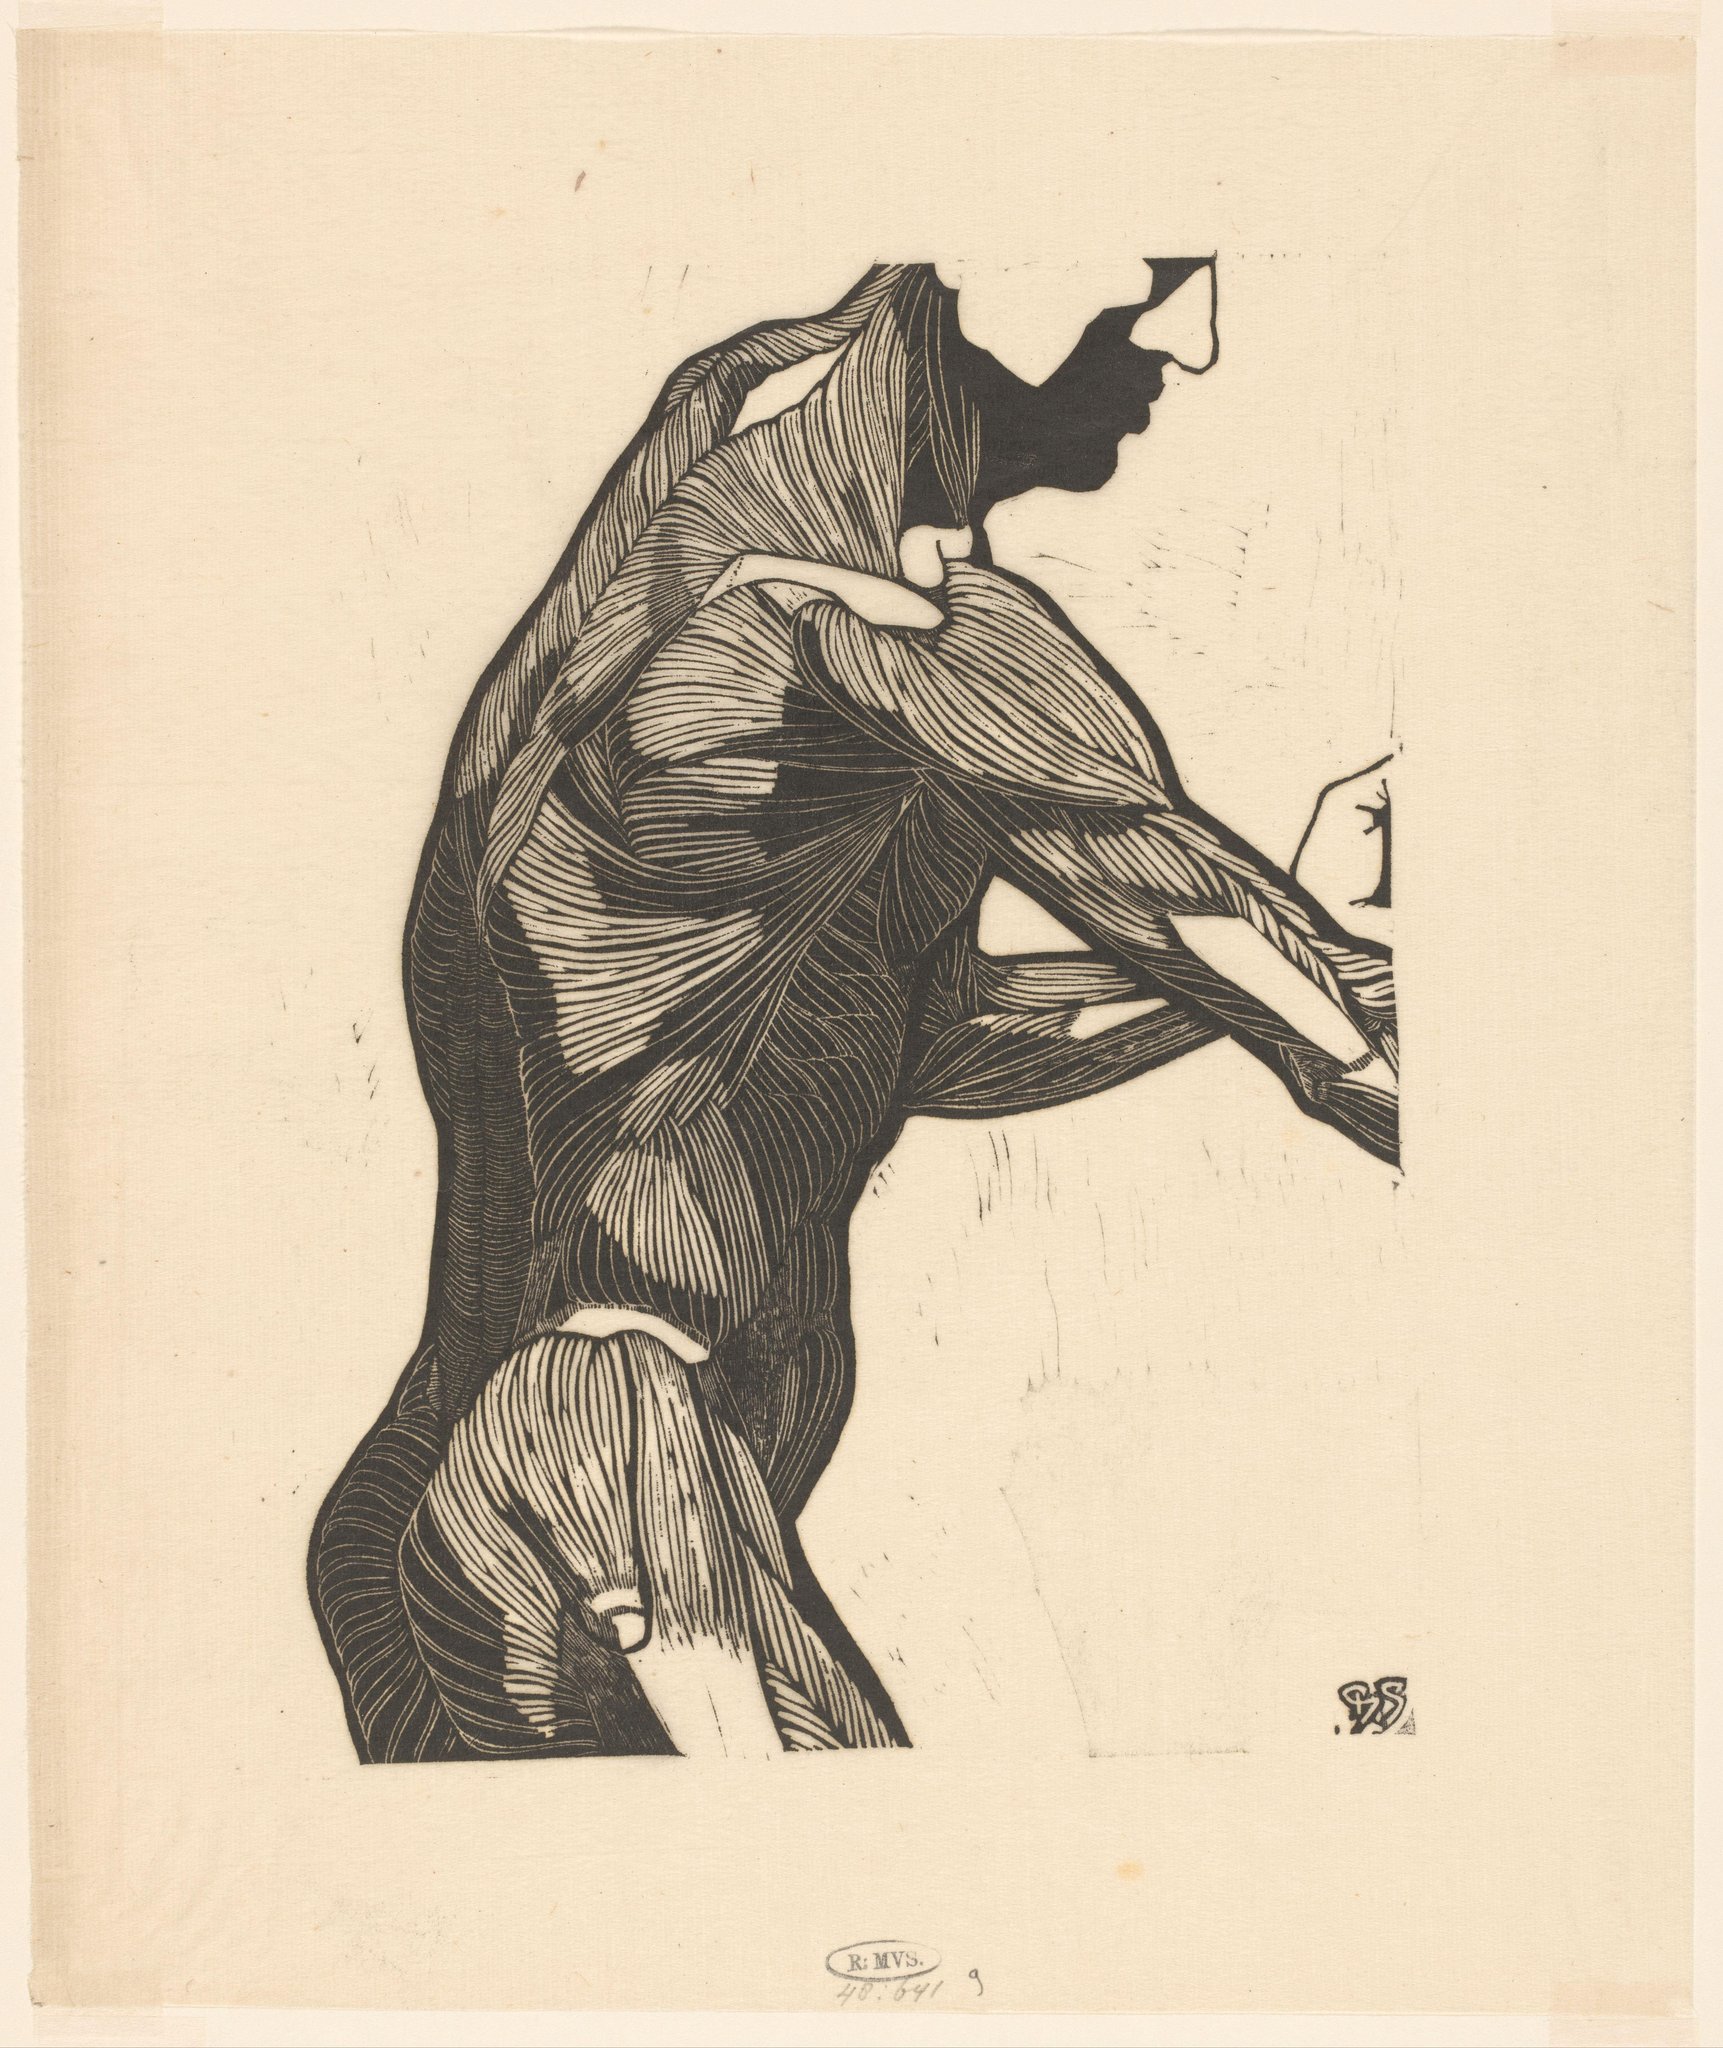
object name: print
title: Anatomische studie van de zij- en armspieren van een man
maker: reijer stolk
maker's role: draughtsman, print maker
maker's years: 1896-1945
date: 1906-1945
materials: paper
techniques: woodcut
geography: netherlands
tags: anatomical model of the muscles, muscle-man, 'écorché'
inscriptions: collector's mark: Lugt 2228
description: Prent gebruikt voor: Stolk, Reyer. Anatomische studies in houtsneden. Amsterdam: G.W. Breughel, 1946, plaat 2.